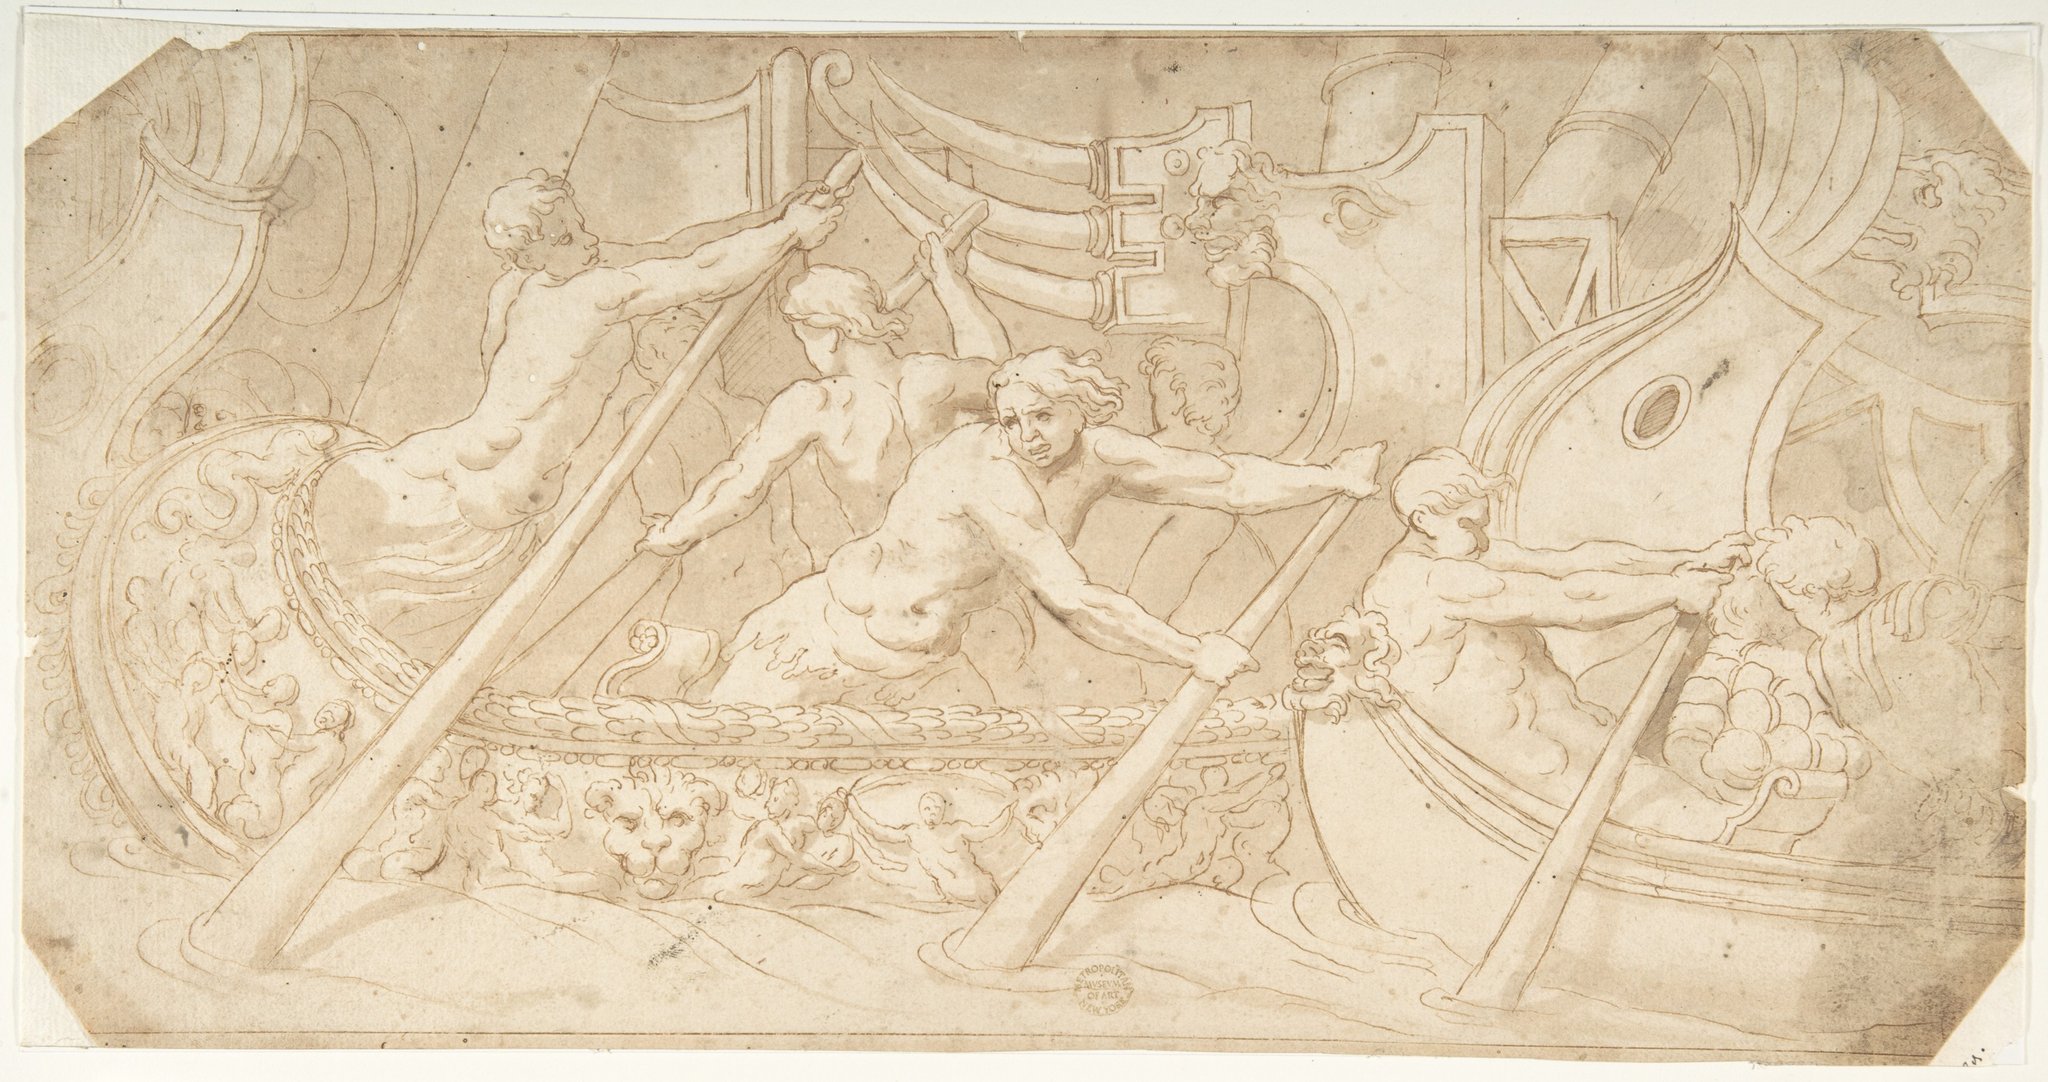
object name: drawing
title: Roman Galley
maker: anonymous, italian, 16th century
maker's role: artist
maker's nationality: italian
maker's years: 1550-1600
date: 1501-1600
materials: ink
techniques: brush, pen, wash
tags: animals,men,boats